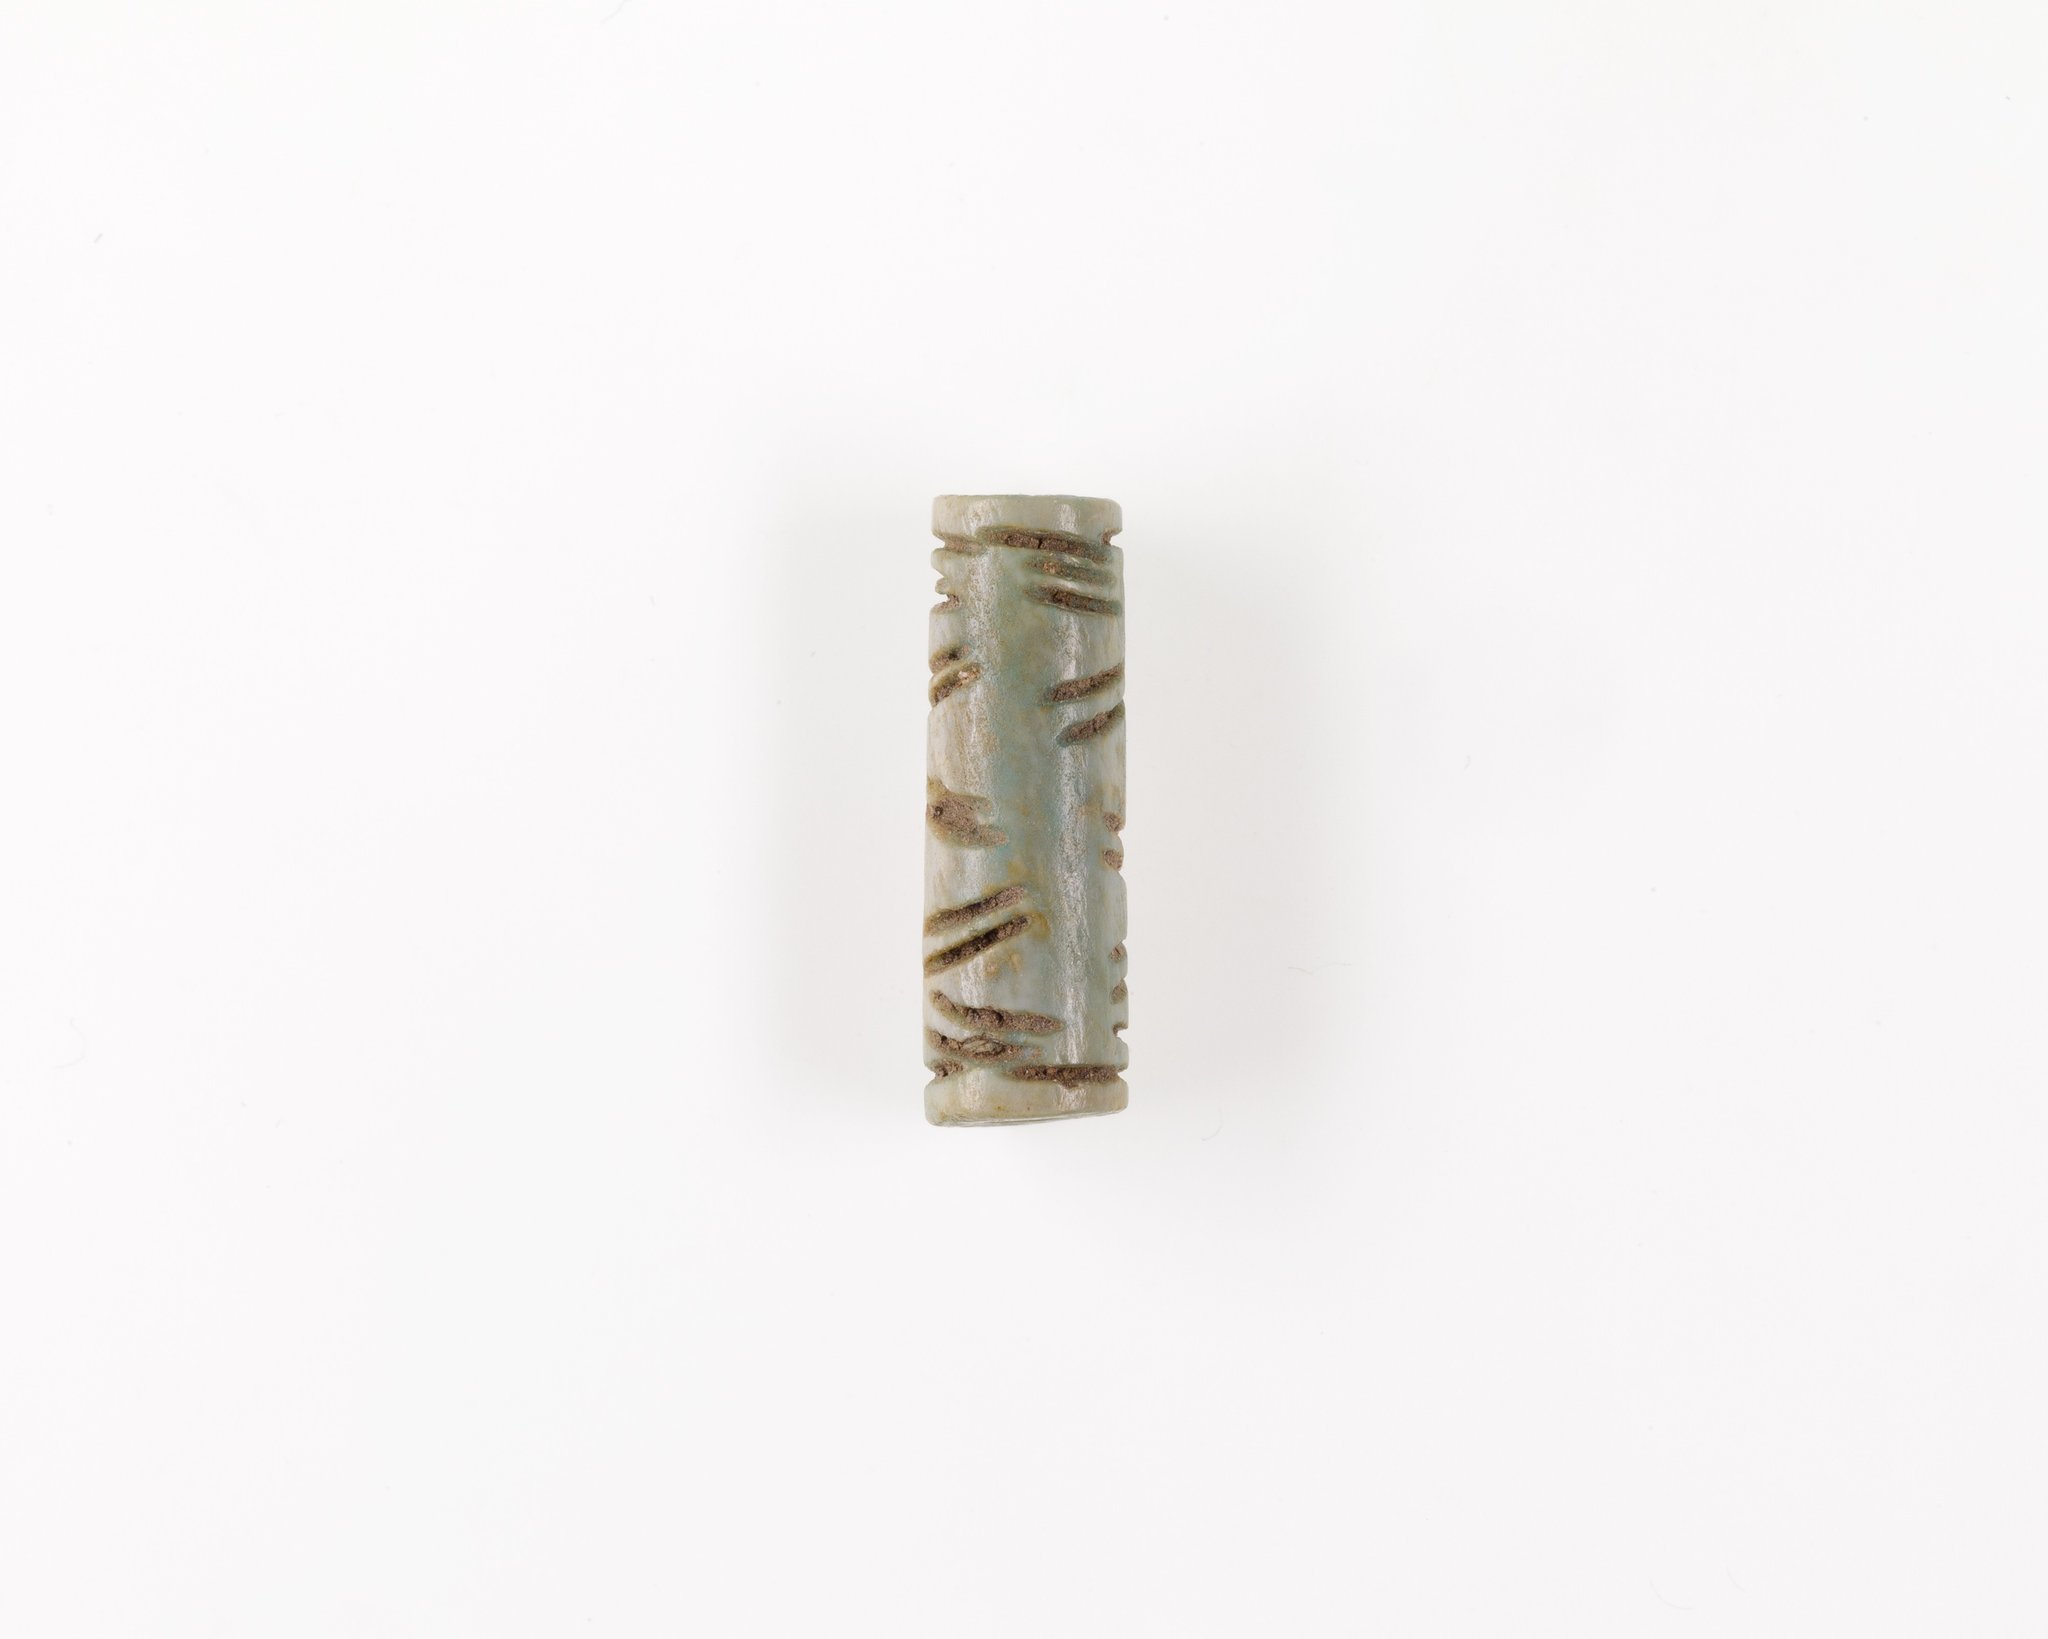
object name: cylinder seal, geometric decoration, crossing line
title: Cylinder Seal or Bead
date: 1981-1295 BCE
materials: faience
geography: egypt